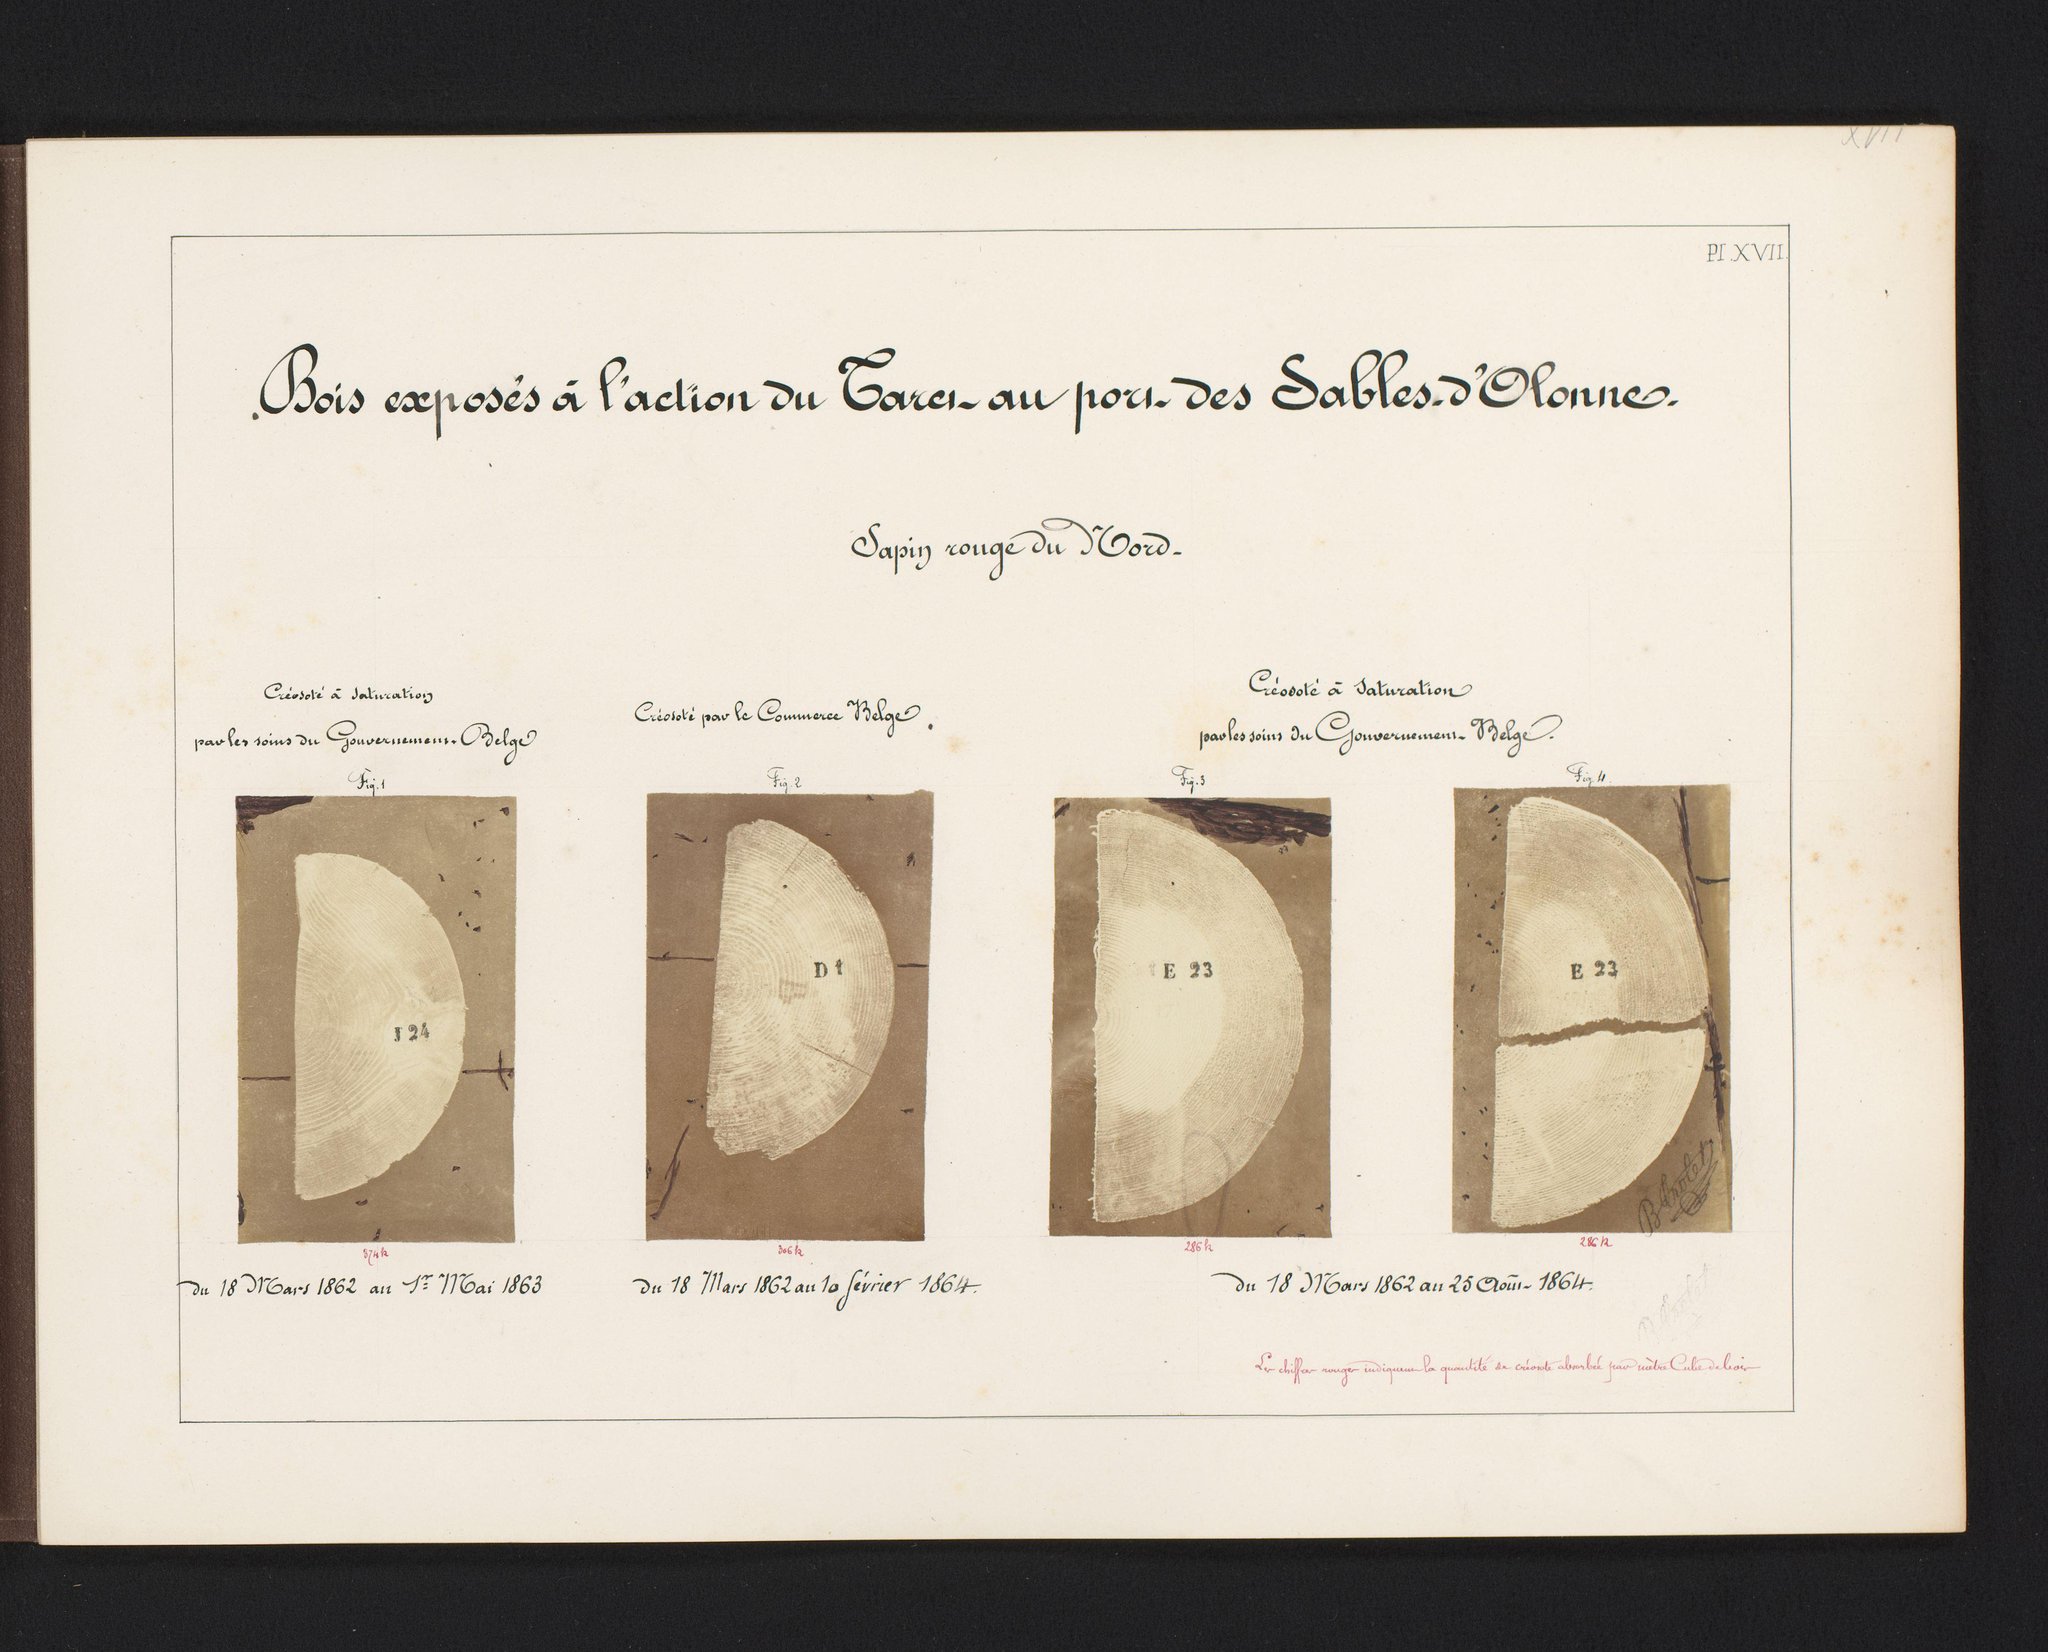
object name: photograph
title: Bois exposés à l'action du Taret au port des Sables-d'Olonne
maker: b. crolet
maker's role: fotograaf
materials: cardboard, photographic support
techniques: albumen print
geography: france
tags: worms, wood, timber ~ building material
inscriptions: signature: ‘B. Crolet’, number: ‘Pl. XVII.’, annotation: ‘Sapin rouge du Nord/ (...)/ mètre Cube de bois.’